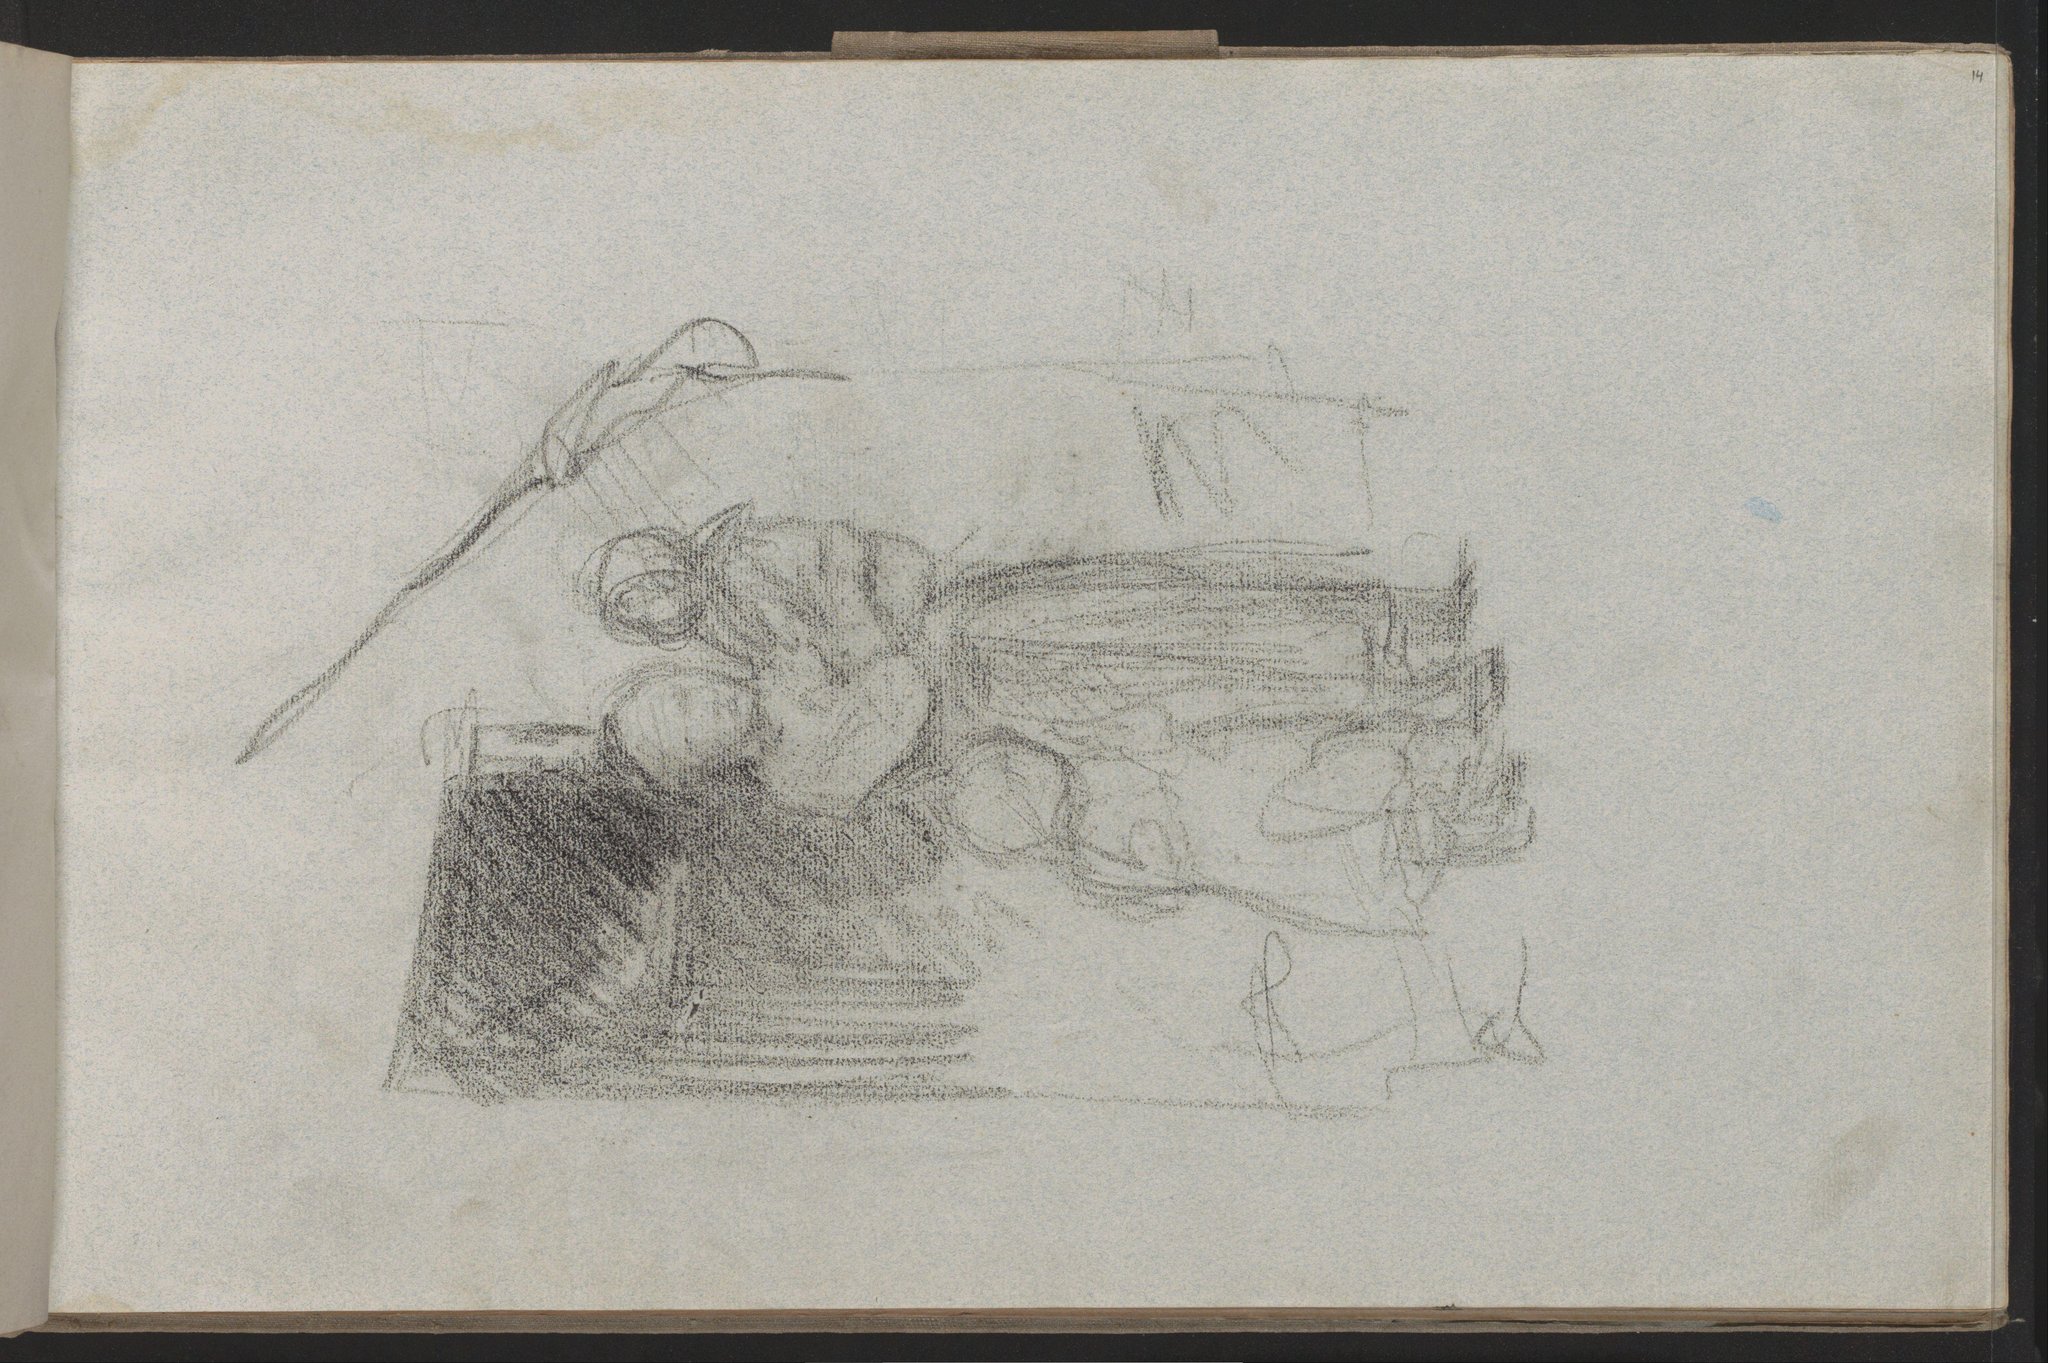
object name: sketchbook leaf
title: Moeder met kinderen voor een deuropening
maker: albert neuhuys (1844-1914)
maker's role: draughtsman, painter, print maker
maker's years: 1844-1914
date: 1854-1914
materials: charcoal, paper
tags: open door, mother and child(ren), woman and child(ren) (family group)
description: Blad 14 recto uit een schetsboek met 51 bladen.